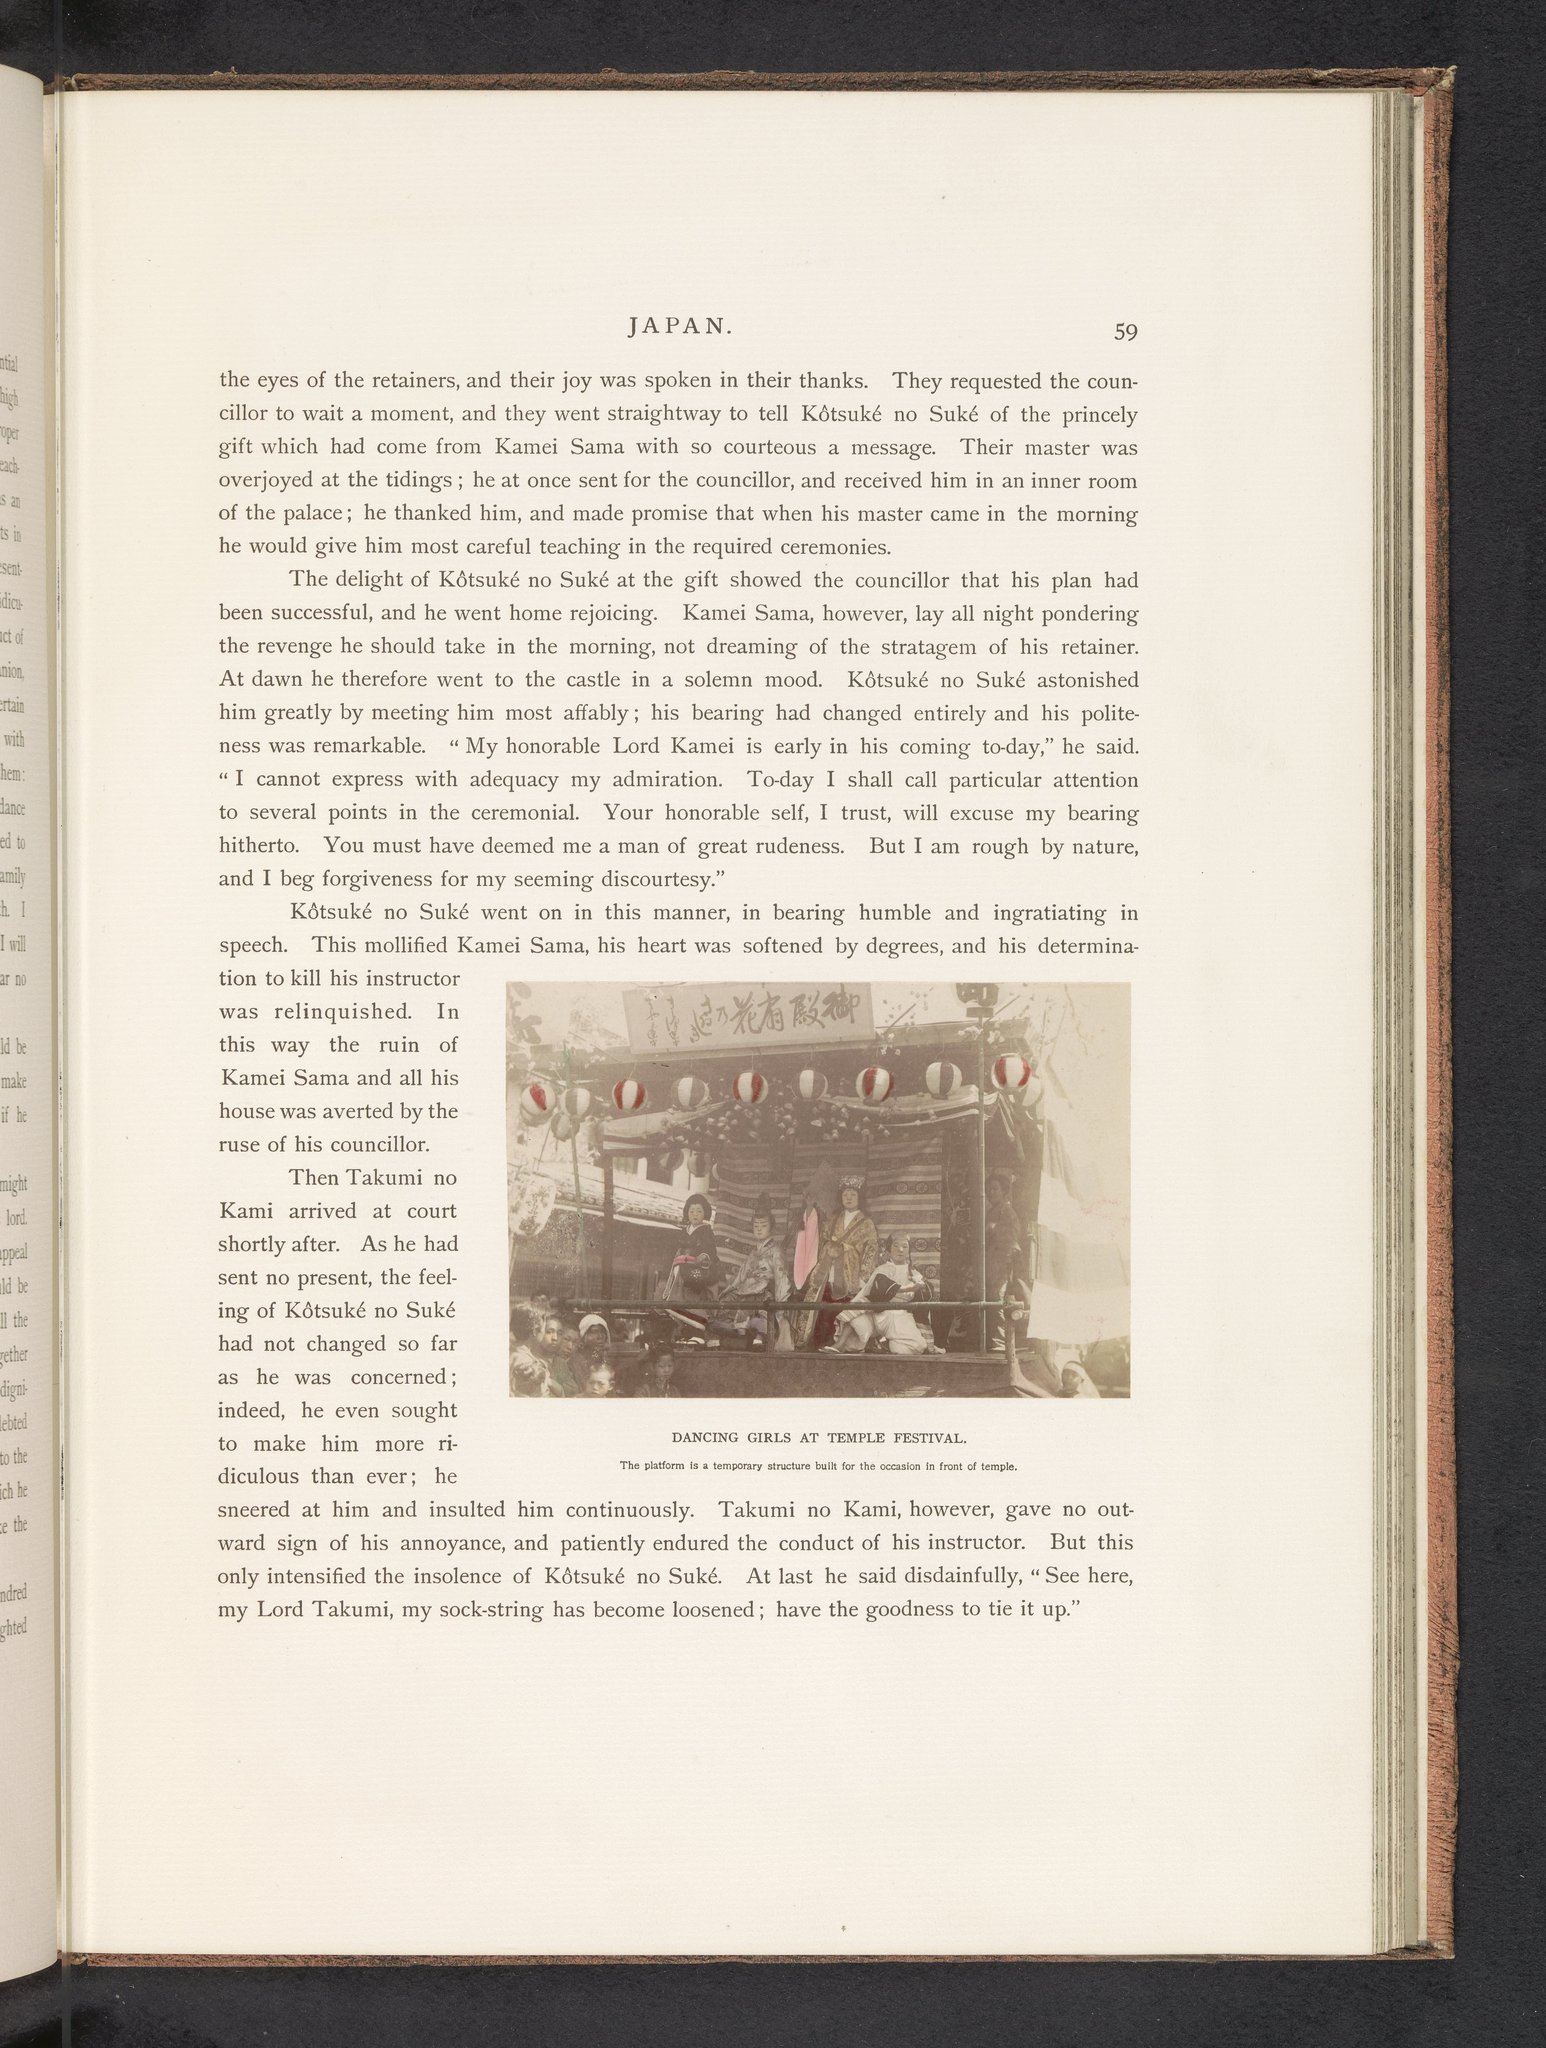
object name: photograph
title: Dancing girls at Temple Festival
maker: Anonymous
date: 1887-1897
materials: photographic support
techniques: albumen print, hand coloring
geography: japan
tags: row dancing (children's games), float ~ triumph, public festivities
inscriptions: inscription: ‘The platform is a temporary structure built for the occasion in front of temple.’